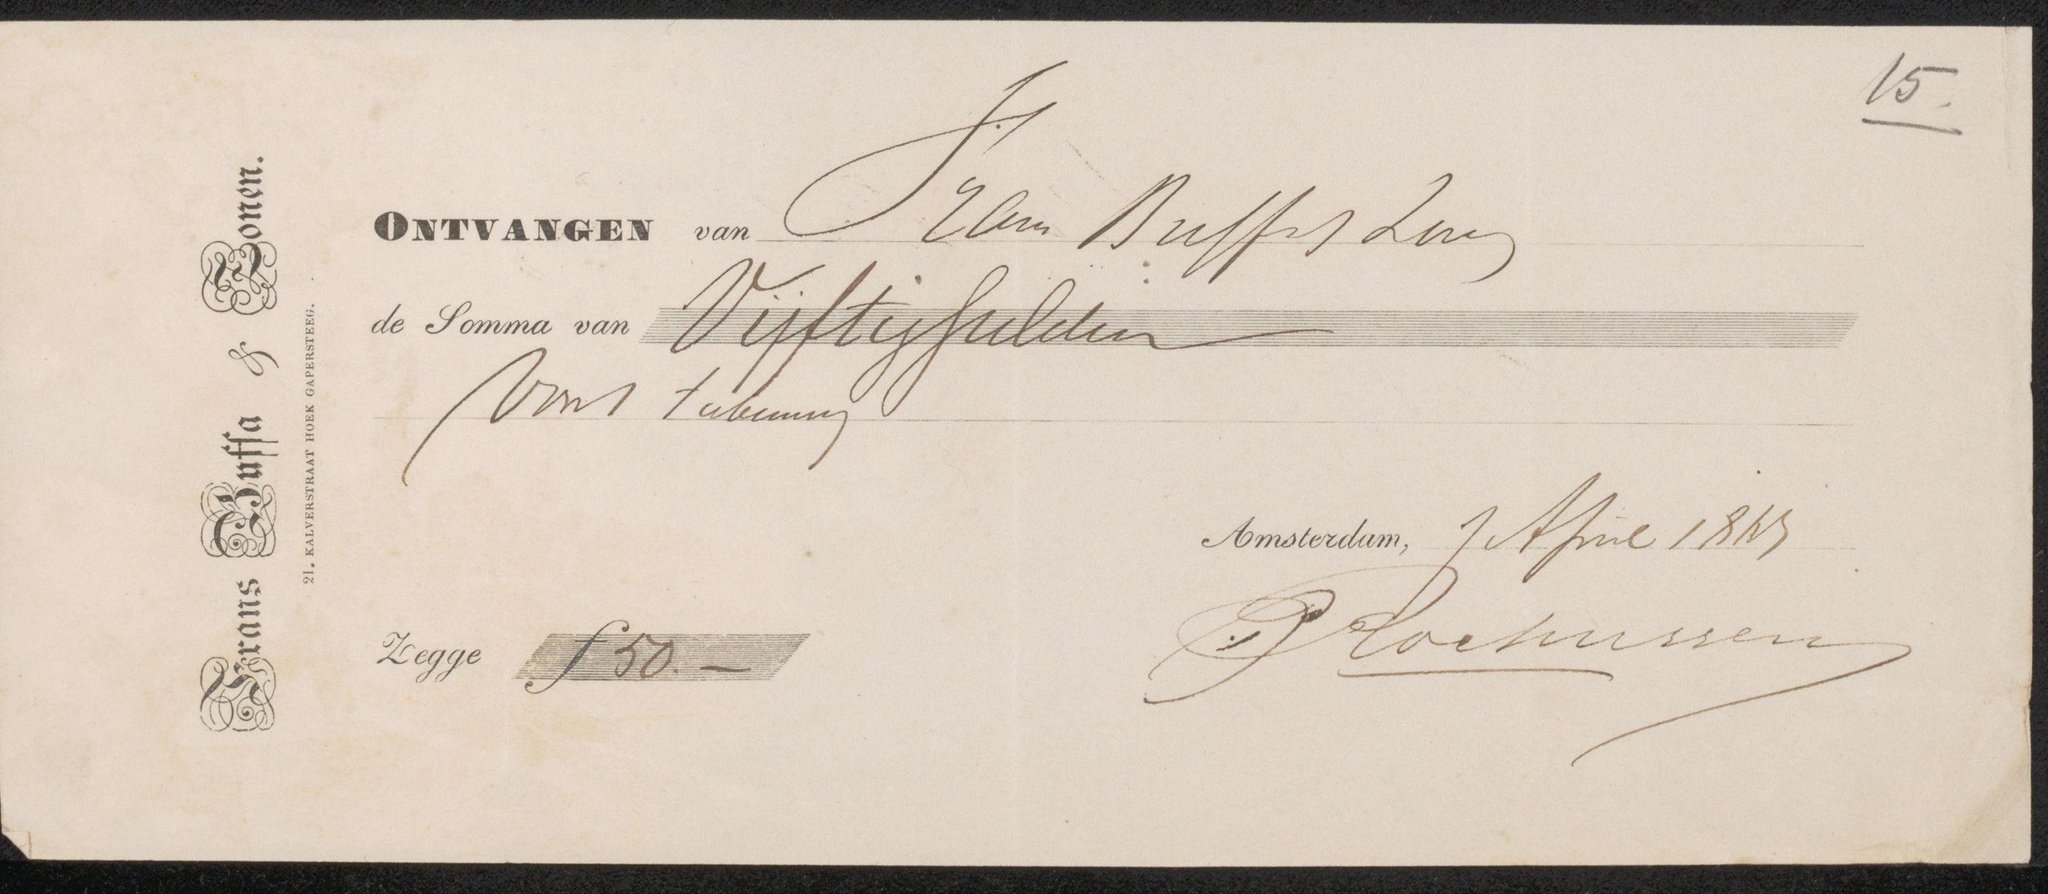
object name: ontvangstbewijs, kwitantie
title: Kwitantie voor Charles Rochussen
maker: charles rochussen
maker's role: draughtsman, painter, print maker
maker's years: 1814-1894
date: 1863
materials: ink, paper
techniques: pen, printing, writing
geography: amsterdam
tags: drawing, money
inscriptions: collector's mark: Lugt 2233